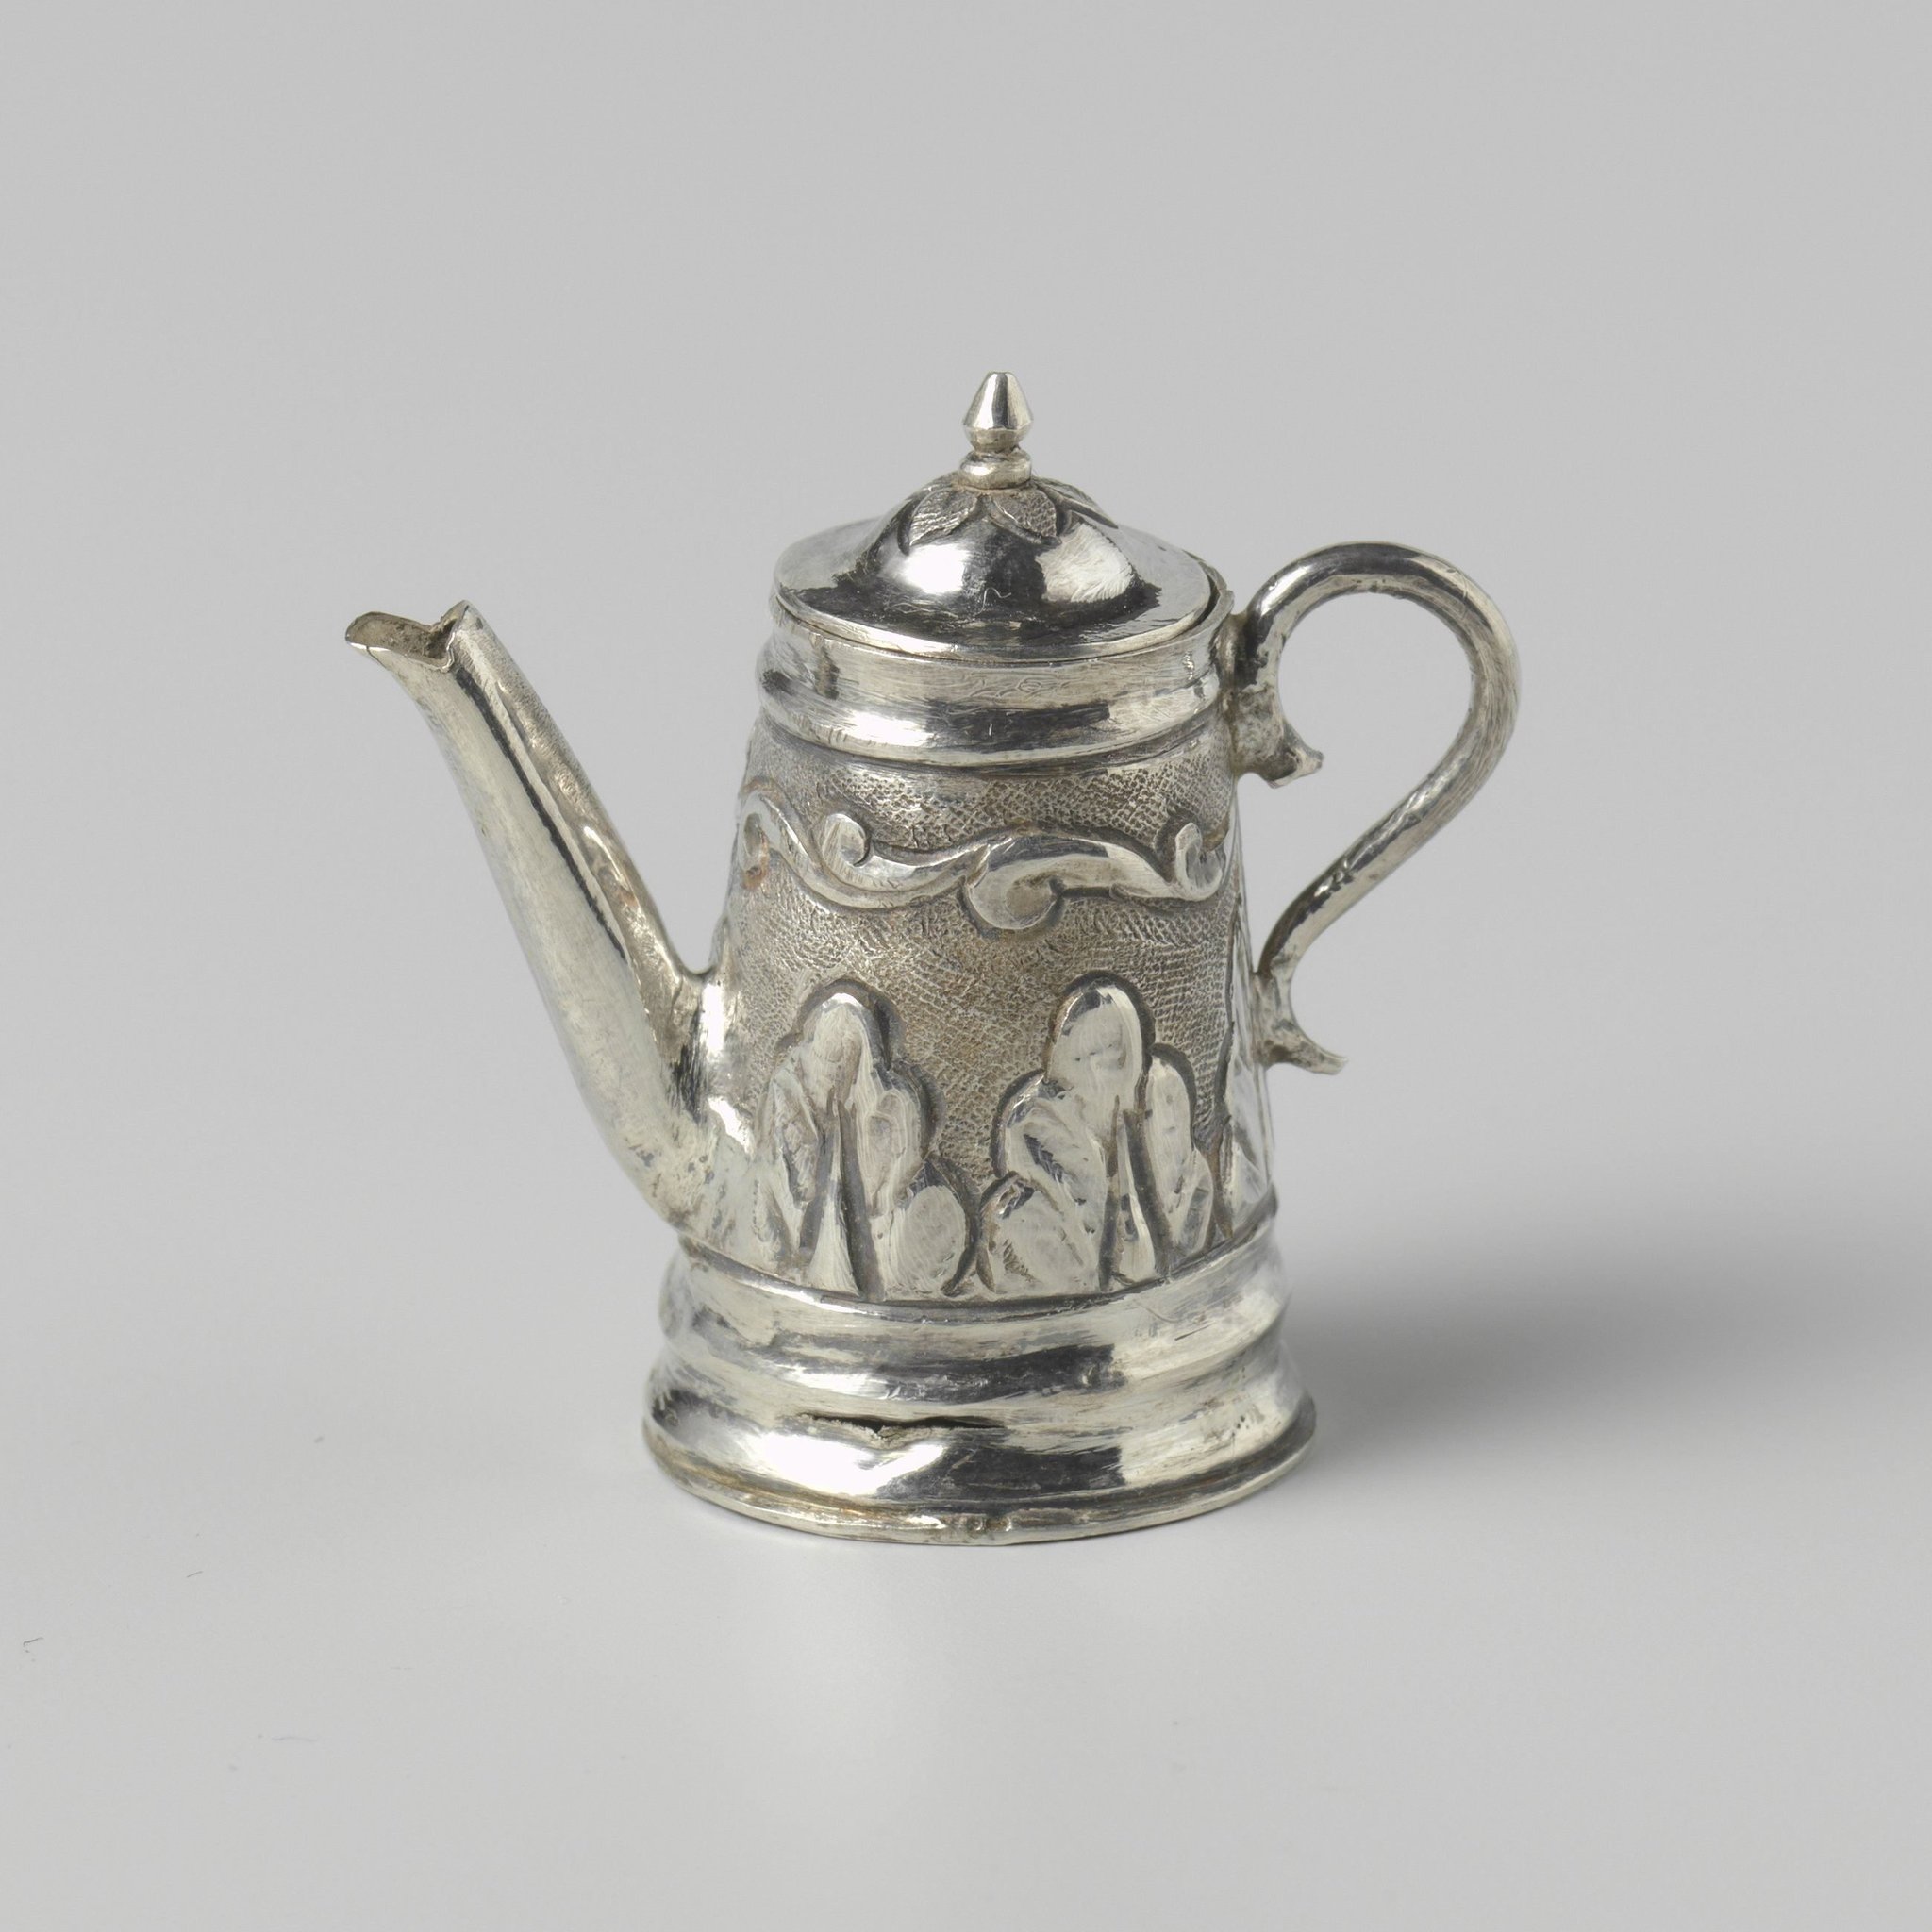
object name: miniature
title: Koffiepot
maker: Anonymous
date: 1814-1898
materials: silver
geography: netherlands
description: Bekervormige koffiepot met een s-vormig handvat en een deksel met knop. De wand van de pot is versierd met acanthusbladeren en rocailleornamenten in relief op een geruwde ondergrond. De koffiepot is gemerkt met een zwaardje. De koffiepot wordt bewaard als onderdeel van een koffie- en theetafel (BK-NM-11177-158).